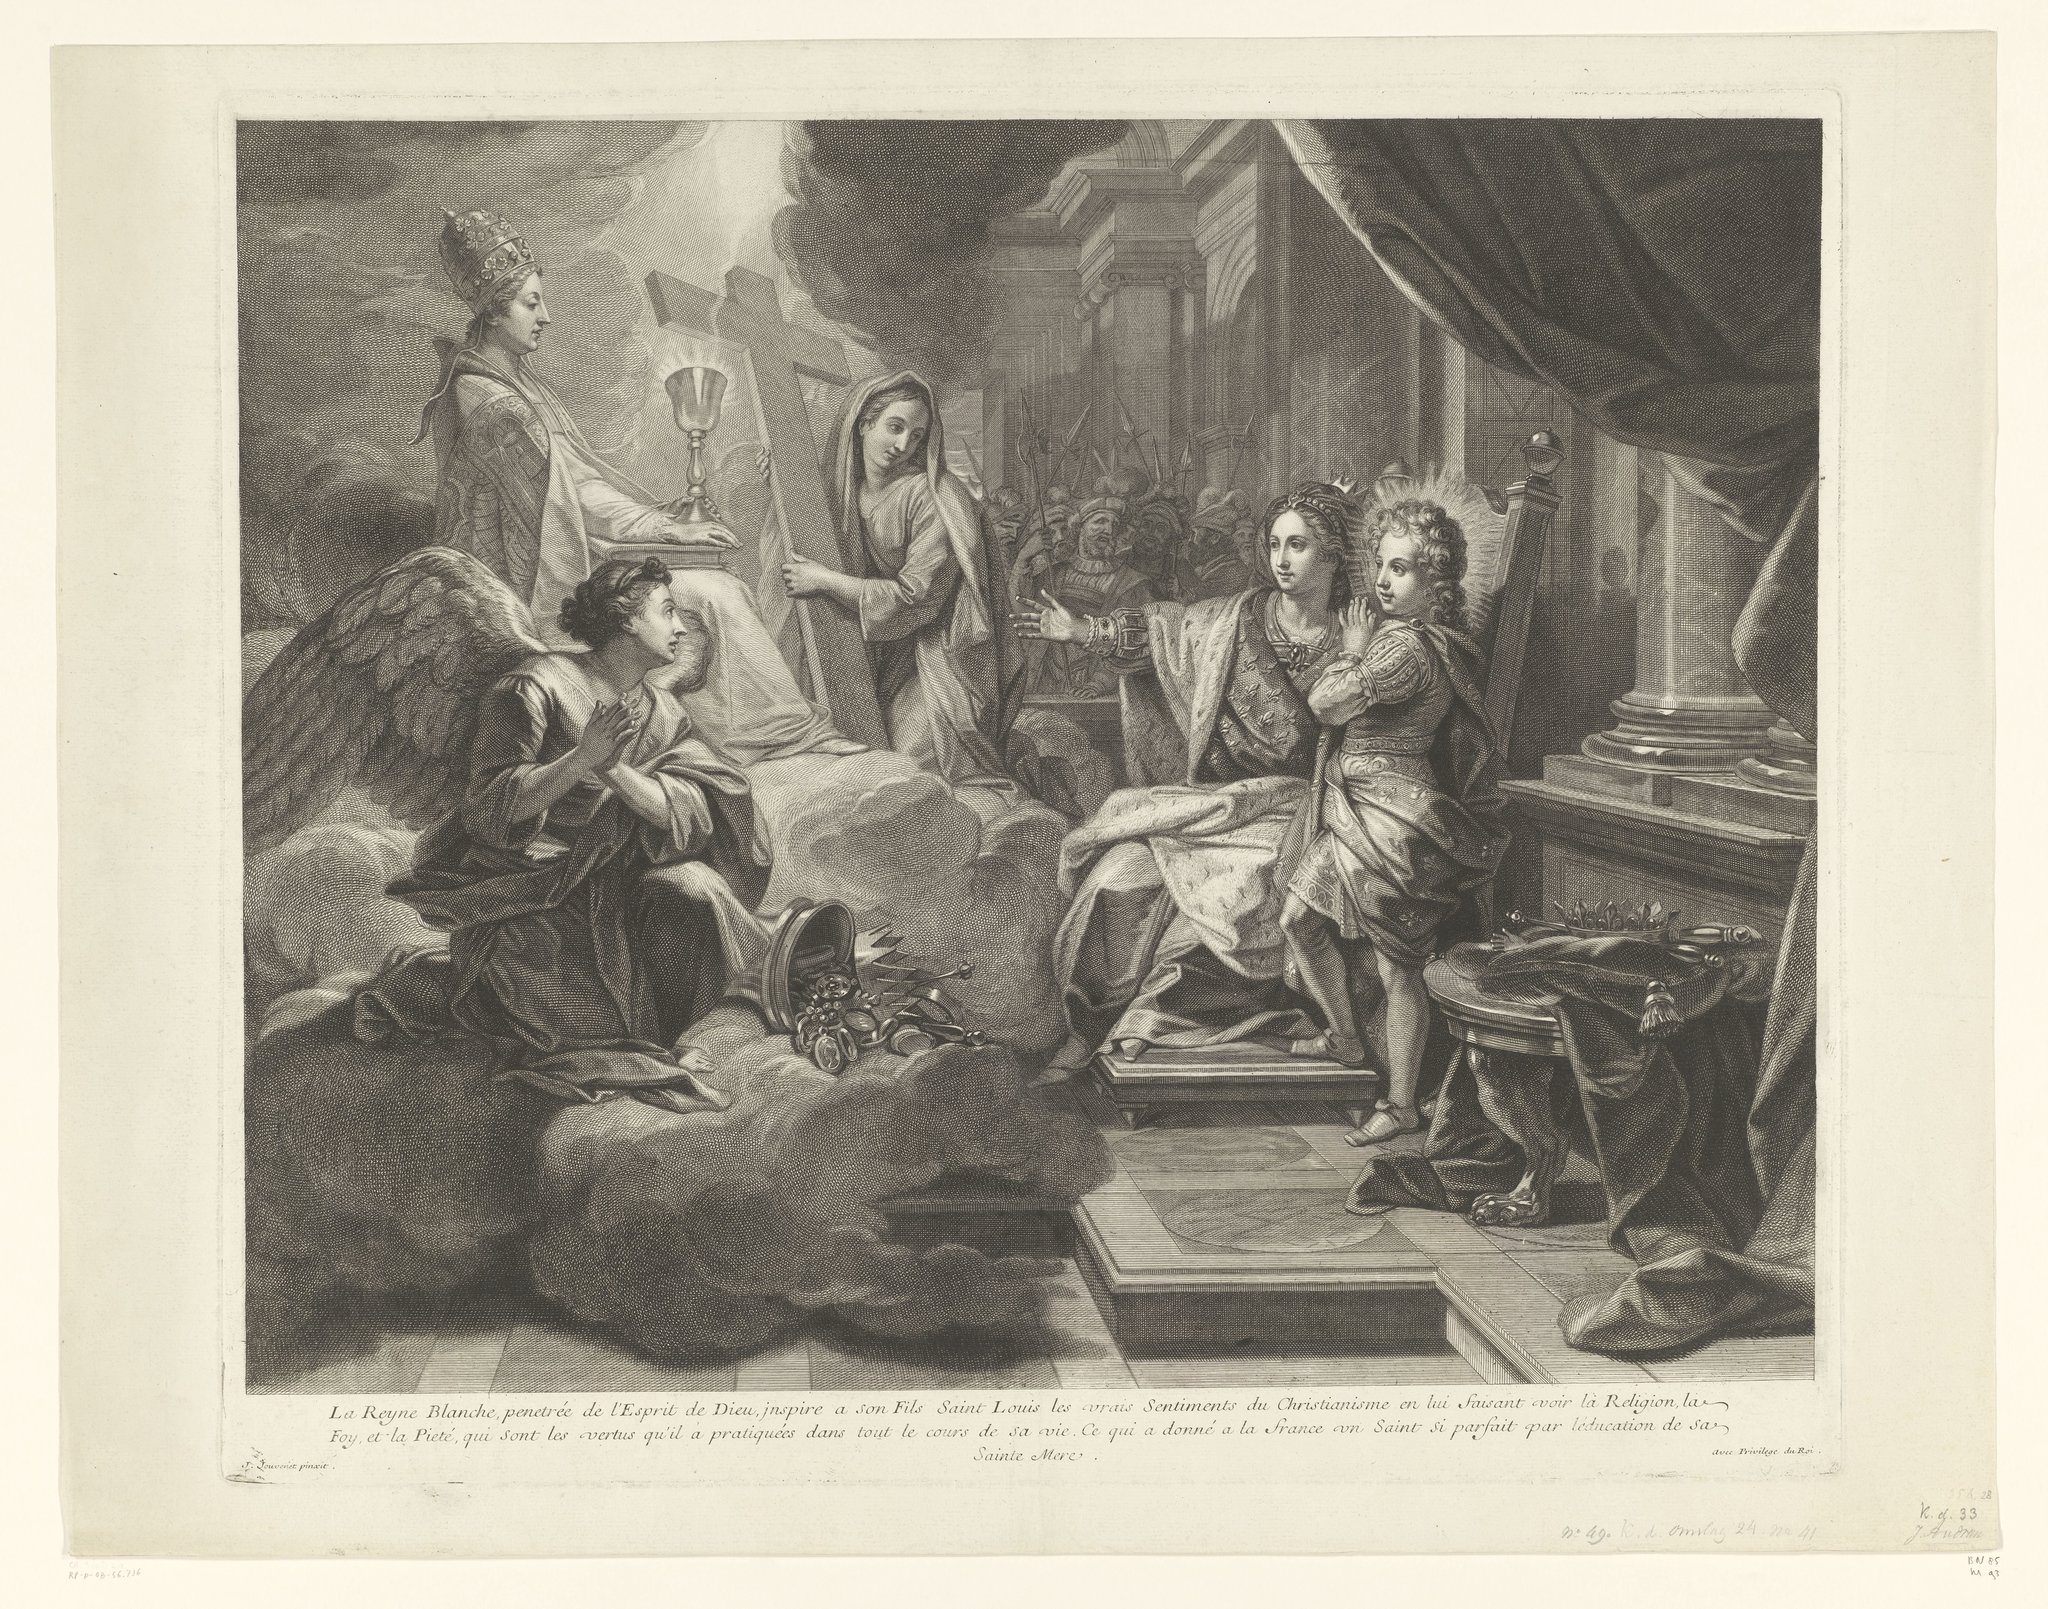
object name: print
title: Blanche van Castilië toont haar zoon Lodewijk IX objecten van het Christendom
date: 1677-1756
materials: paper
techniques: engraving, etching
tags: paris, christian doctrine, the cross ~ symbols of christ, the church personified, 'ecclesia', usually with chalice and banner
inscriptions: collector's mark: Lugt 240